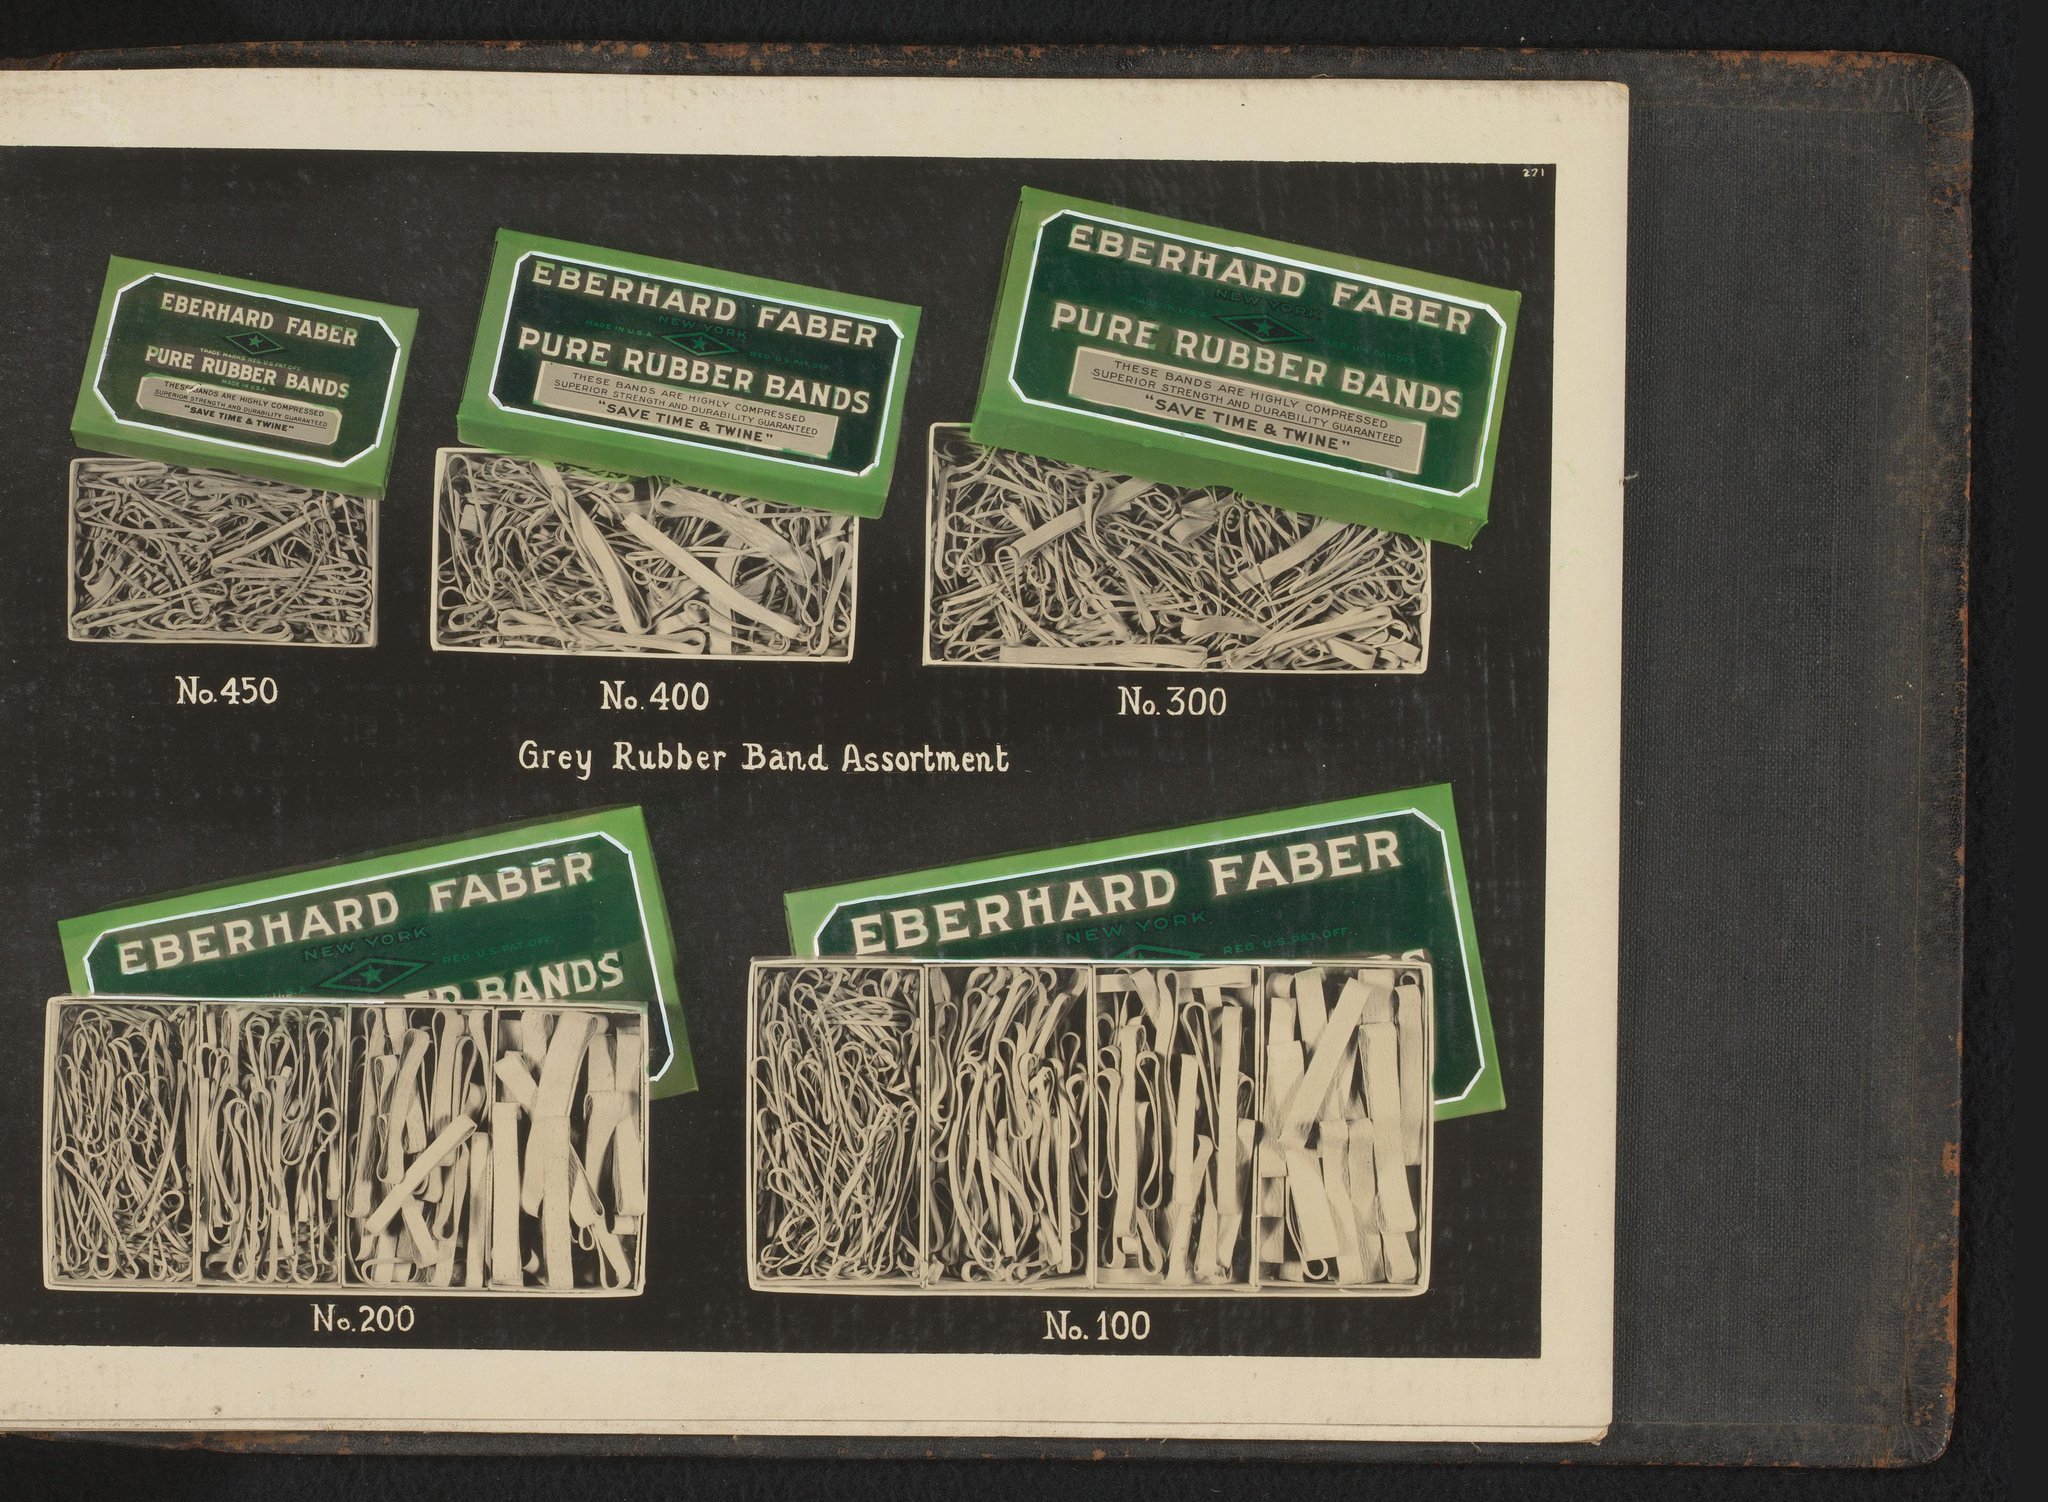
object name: album leaf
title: Dozen met elastieken van Eberhard Faber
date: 1915-1935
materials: paper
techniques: gelatin silver print, hand coloring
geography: springfield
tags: writing accessories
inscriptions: stamp: ‘Paramount/ Commercial Studios/ 145 Chestnut St./ Springfield - Mass.’, number: ‘271’